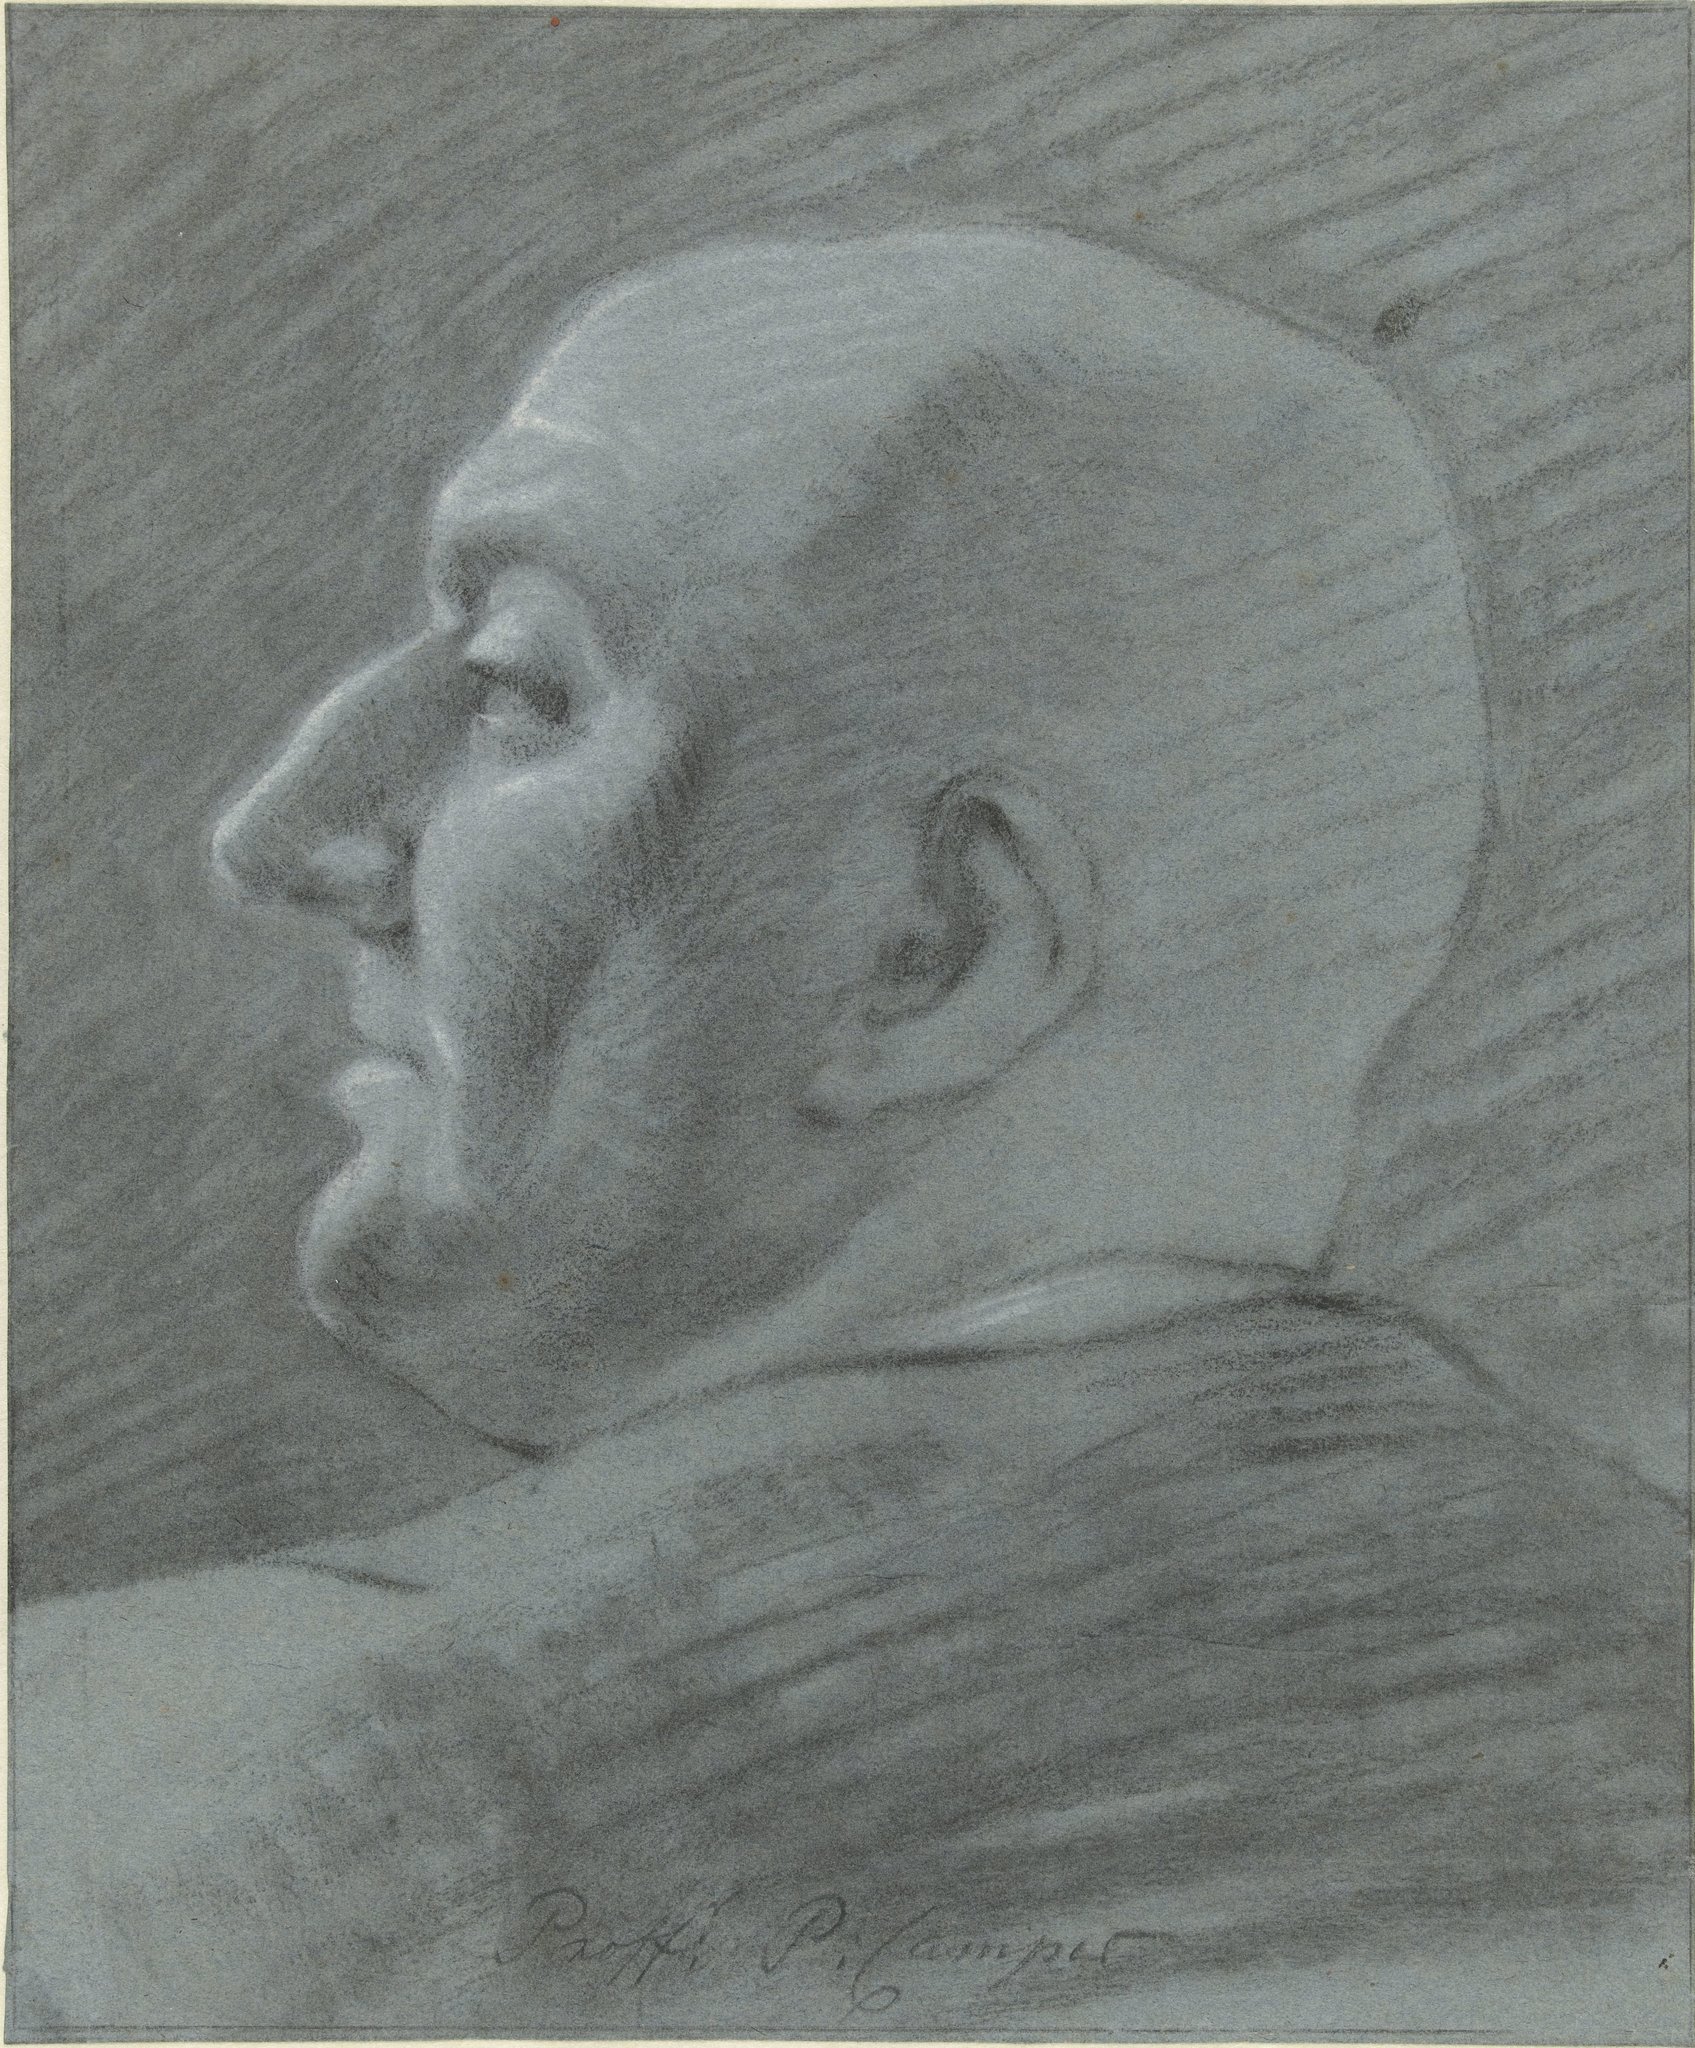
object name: drawing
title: Portret van Petrus Camper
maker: jurriaan andriessen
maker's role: draughtsman, painter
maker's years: 1742-1819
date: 1774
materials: chalk, paper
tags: leiden, print maker, petrus camper, historical persons, portrait, self-portrait of artist, portrait, self-portrait of draughtsman